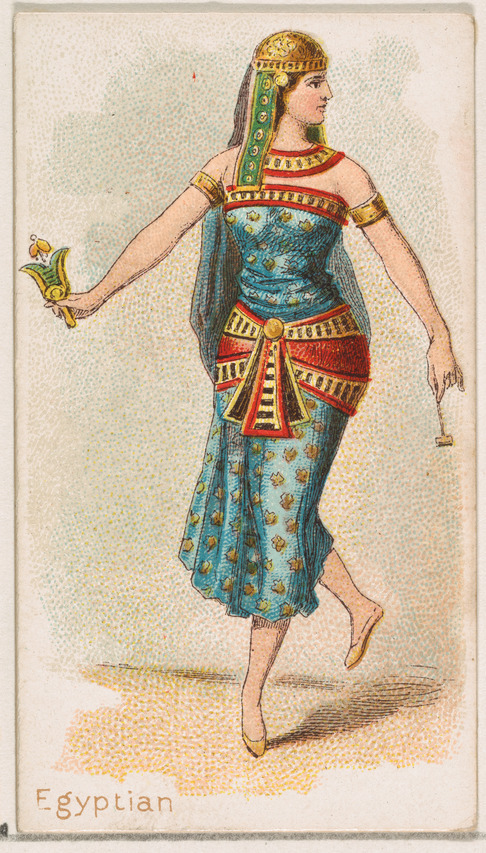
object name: print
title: Egyptian Dancer, from the Dancing Women series (N186) issued by Wm. S. Kimball & Co.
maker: william s. kimball & company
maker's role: publisher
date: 1889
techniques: color lithograph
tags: profiles,women,dancers